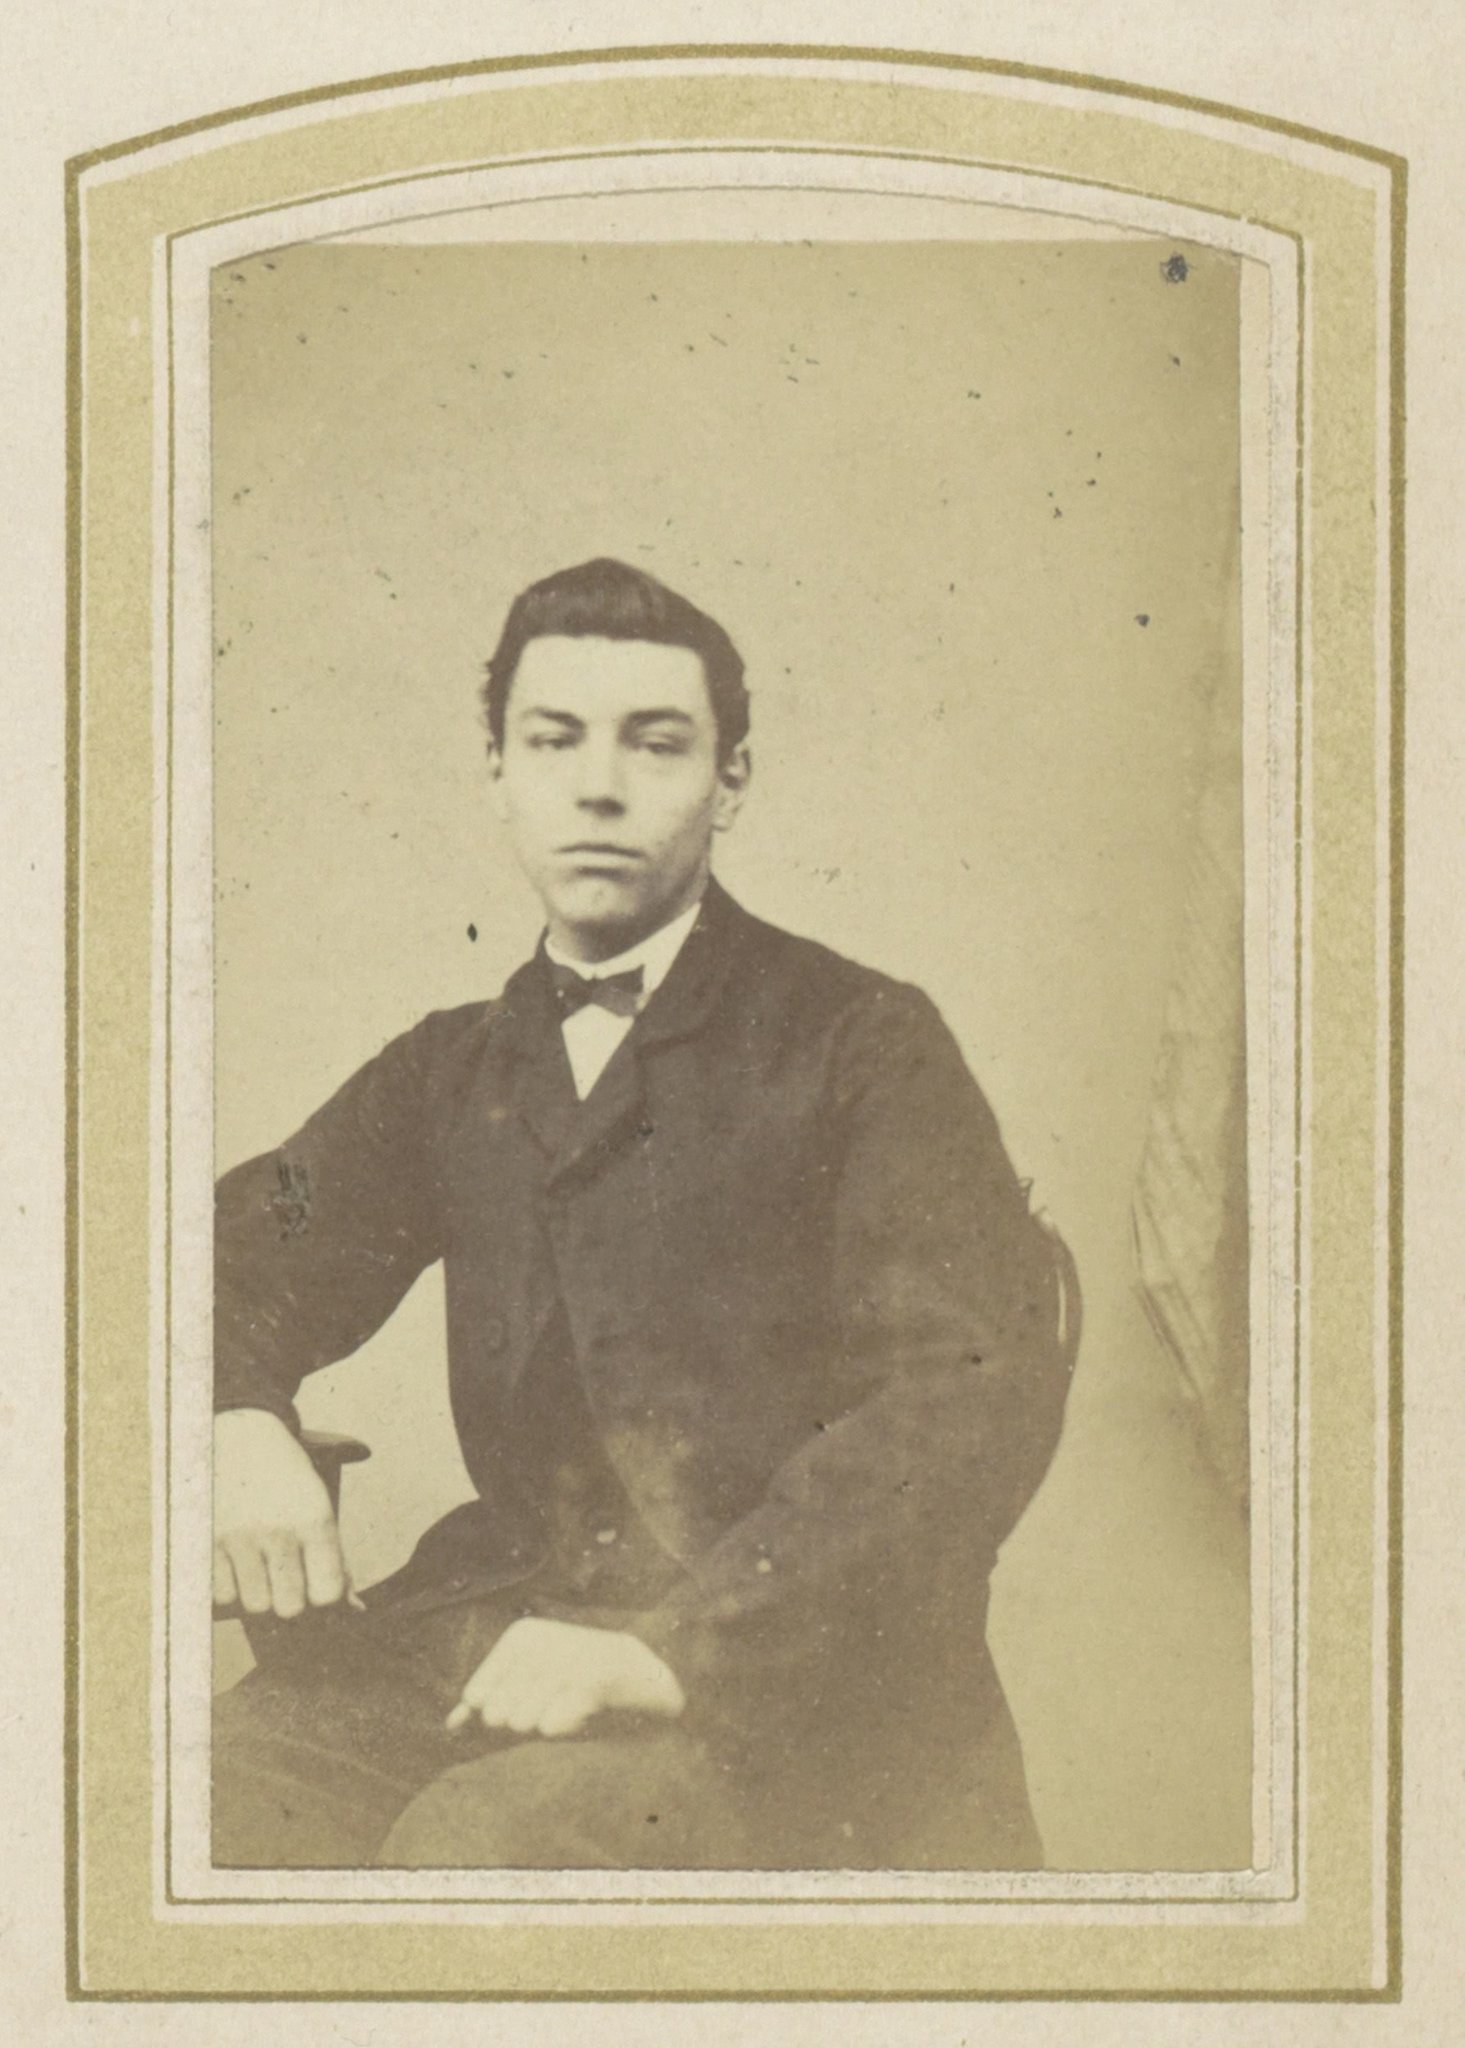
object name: photograph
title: Portret van een jongeman met een strik en een jas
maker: Anonymous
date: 1860-1900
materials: cardboard, paper, photographic support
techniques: albumen print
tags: studio requisites ~ photographer, historical persons, neck-gear ~ clothing, clothing for the upper part of the body, hairdress, coat, cape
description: Onderdeel van Fotoalbum van een Nederlandse familie met 168 cartes-de-visite en kabinetfoto's.